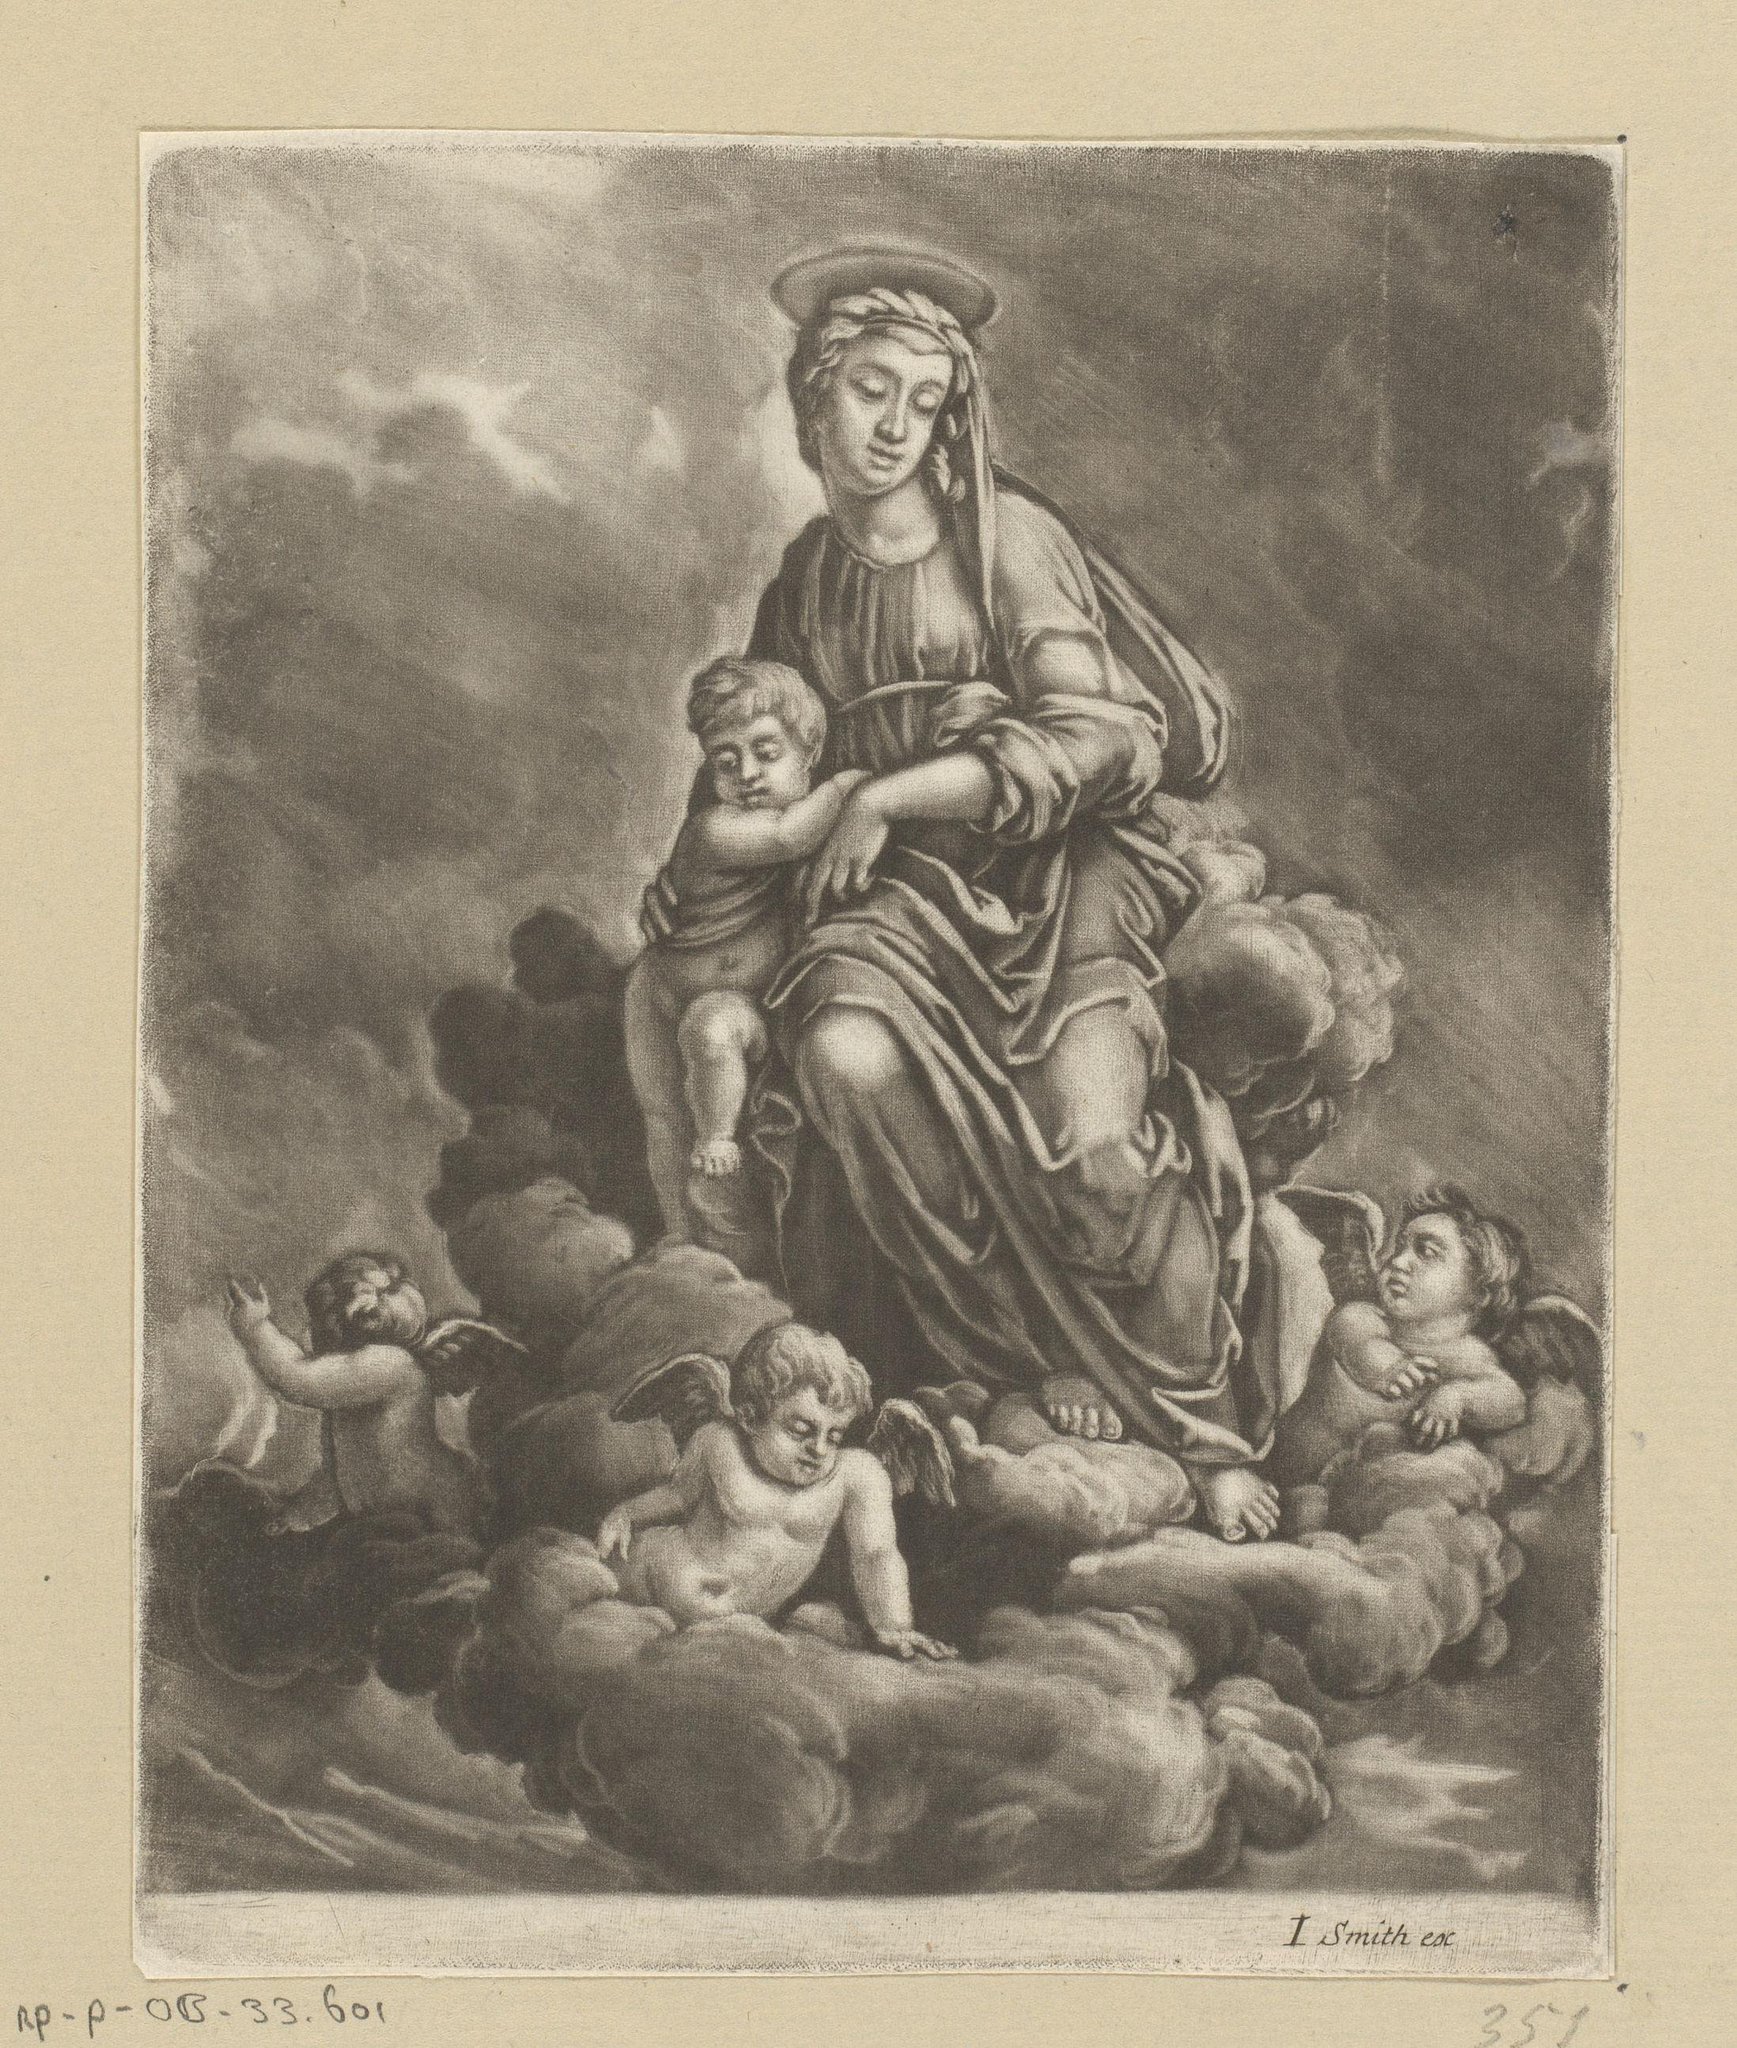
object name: print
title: Maria met kind en putti op een wolk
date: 1680-1730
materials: paper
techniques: mezzotint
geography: england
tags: madonna: mary (standing) with the christ-child free-standing (or leaning against her) (+ angel(s))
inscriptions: collector's mark: Lugt 240